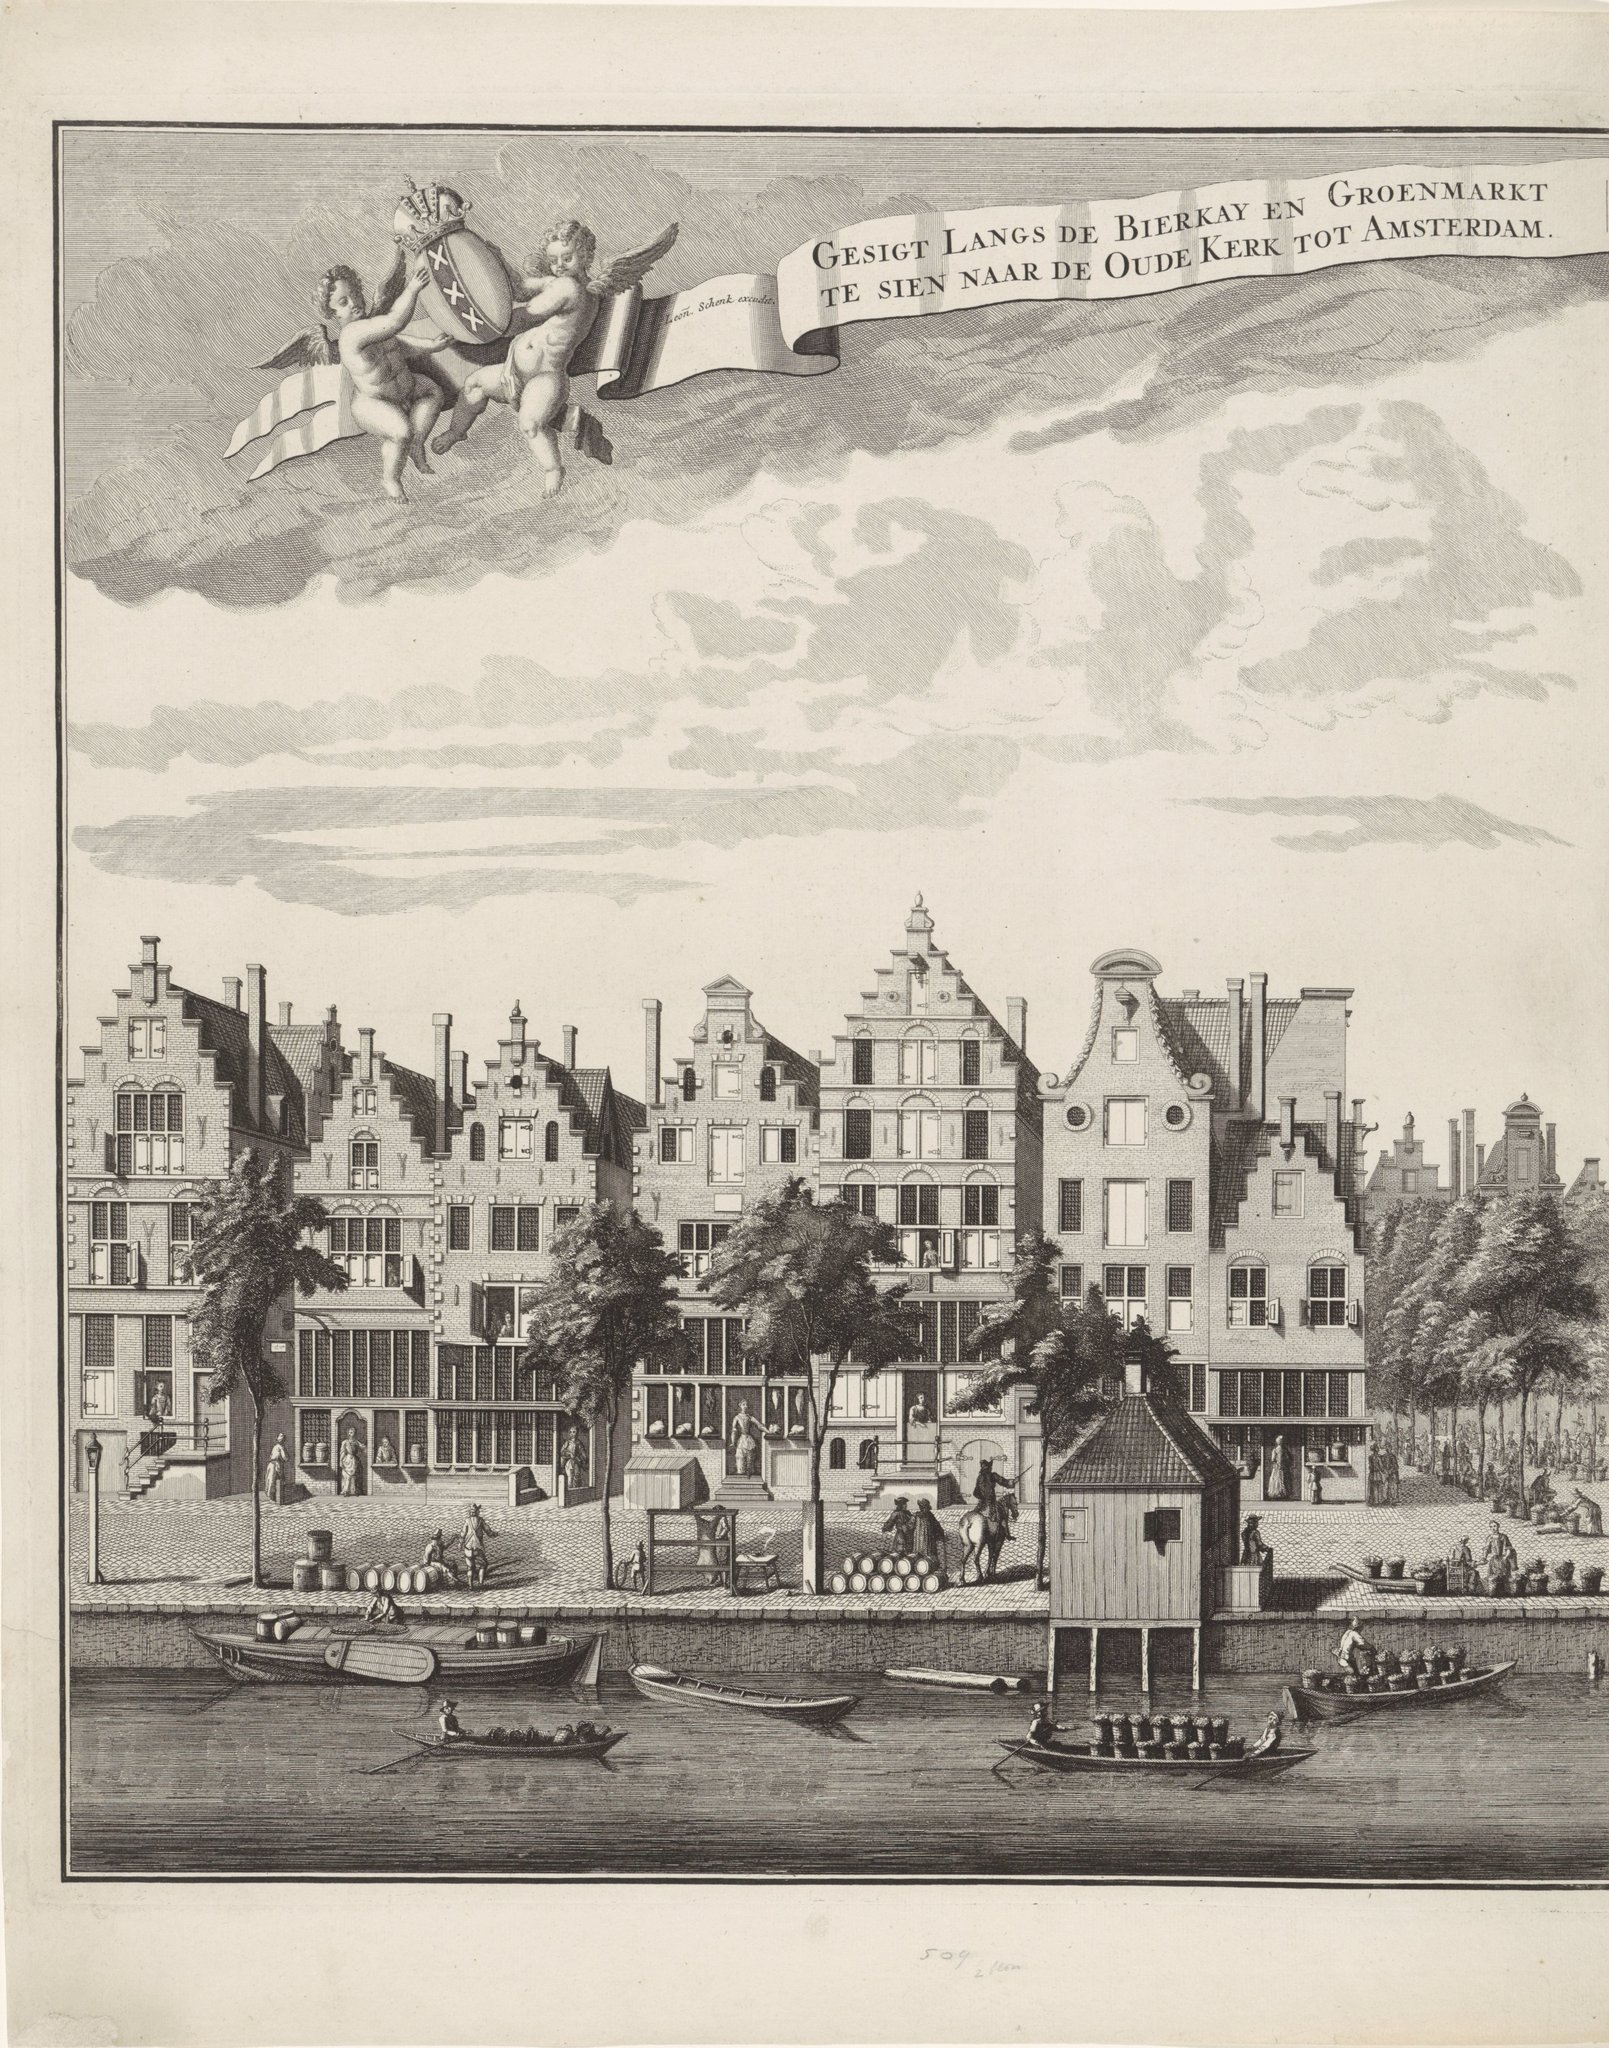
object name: print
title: Gesigt Langs de Bierkay en Groenmarkt te sien naar de Oude Kerk tot Amsterdam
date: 1731-1747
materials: paper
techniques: etching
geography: amsterdam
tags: rowing-boat, canoe, etc., market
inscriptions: collector's mark: Lugt 2228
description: Gezicht op een gedeelte van de Oudezijds Voorburgwal bij de Oude Kerk te Amsterdam. Op de gracht worden producten in manden op roeiboten vervoerd en op de Oudezijds Voorburgwal staan tonnen en lopen mensen. Rechts op het Oudekerksplein is een markt gaande.